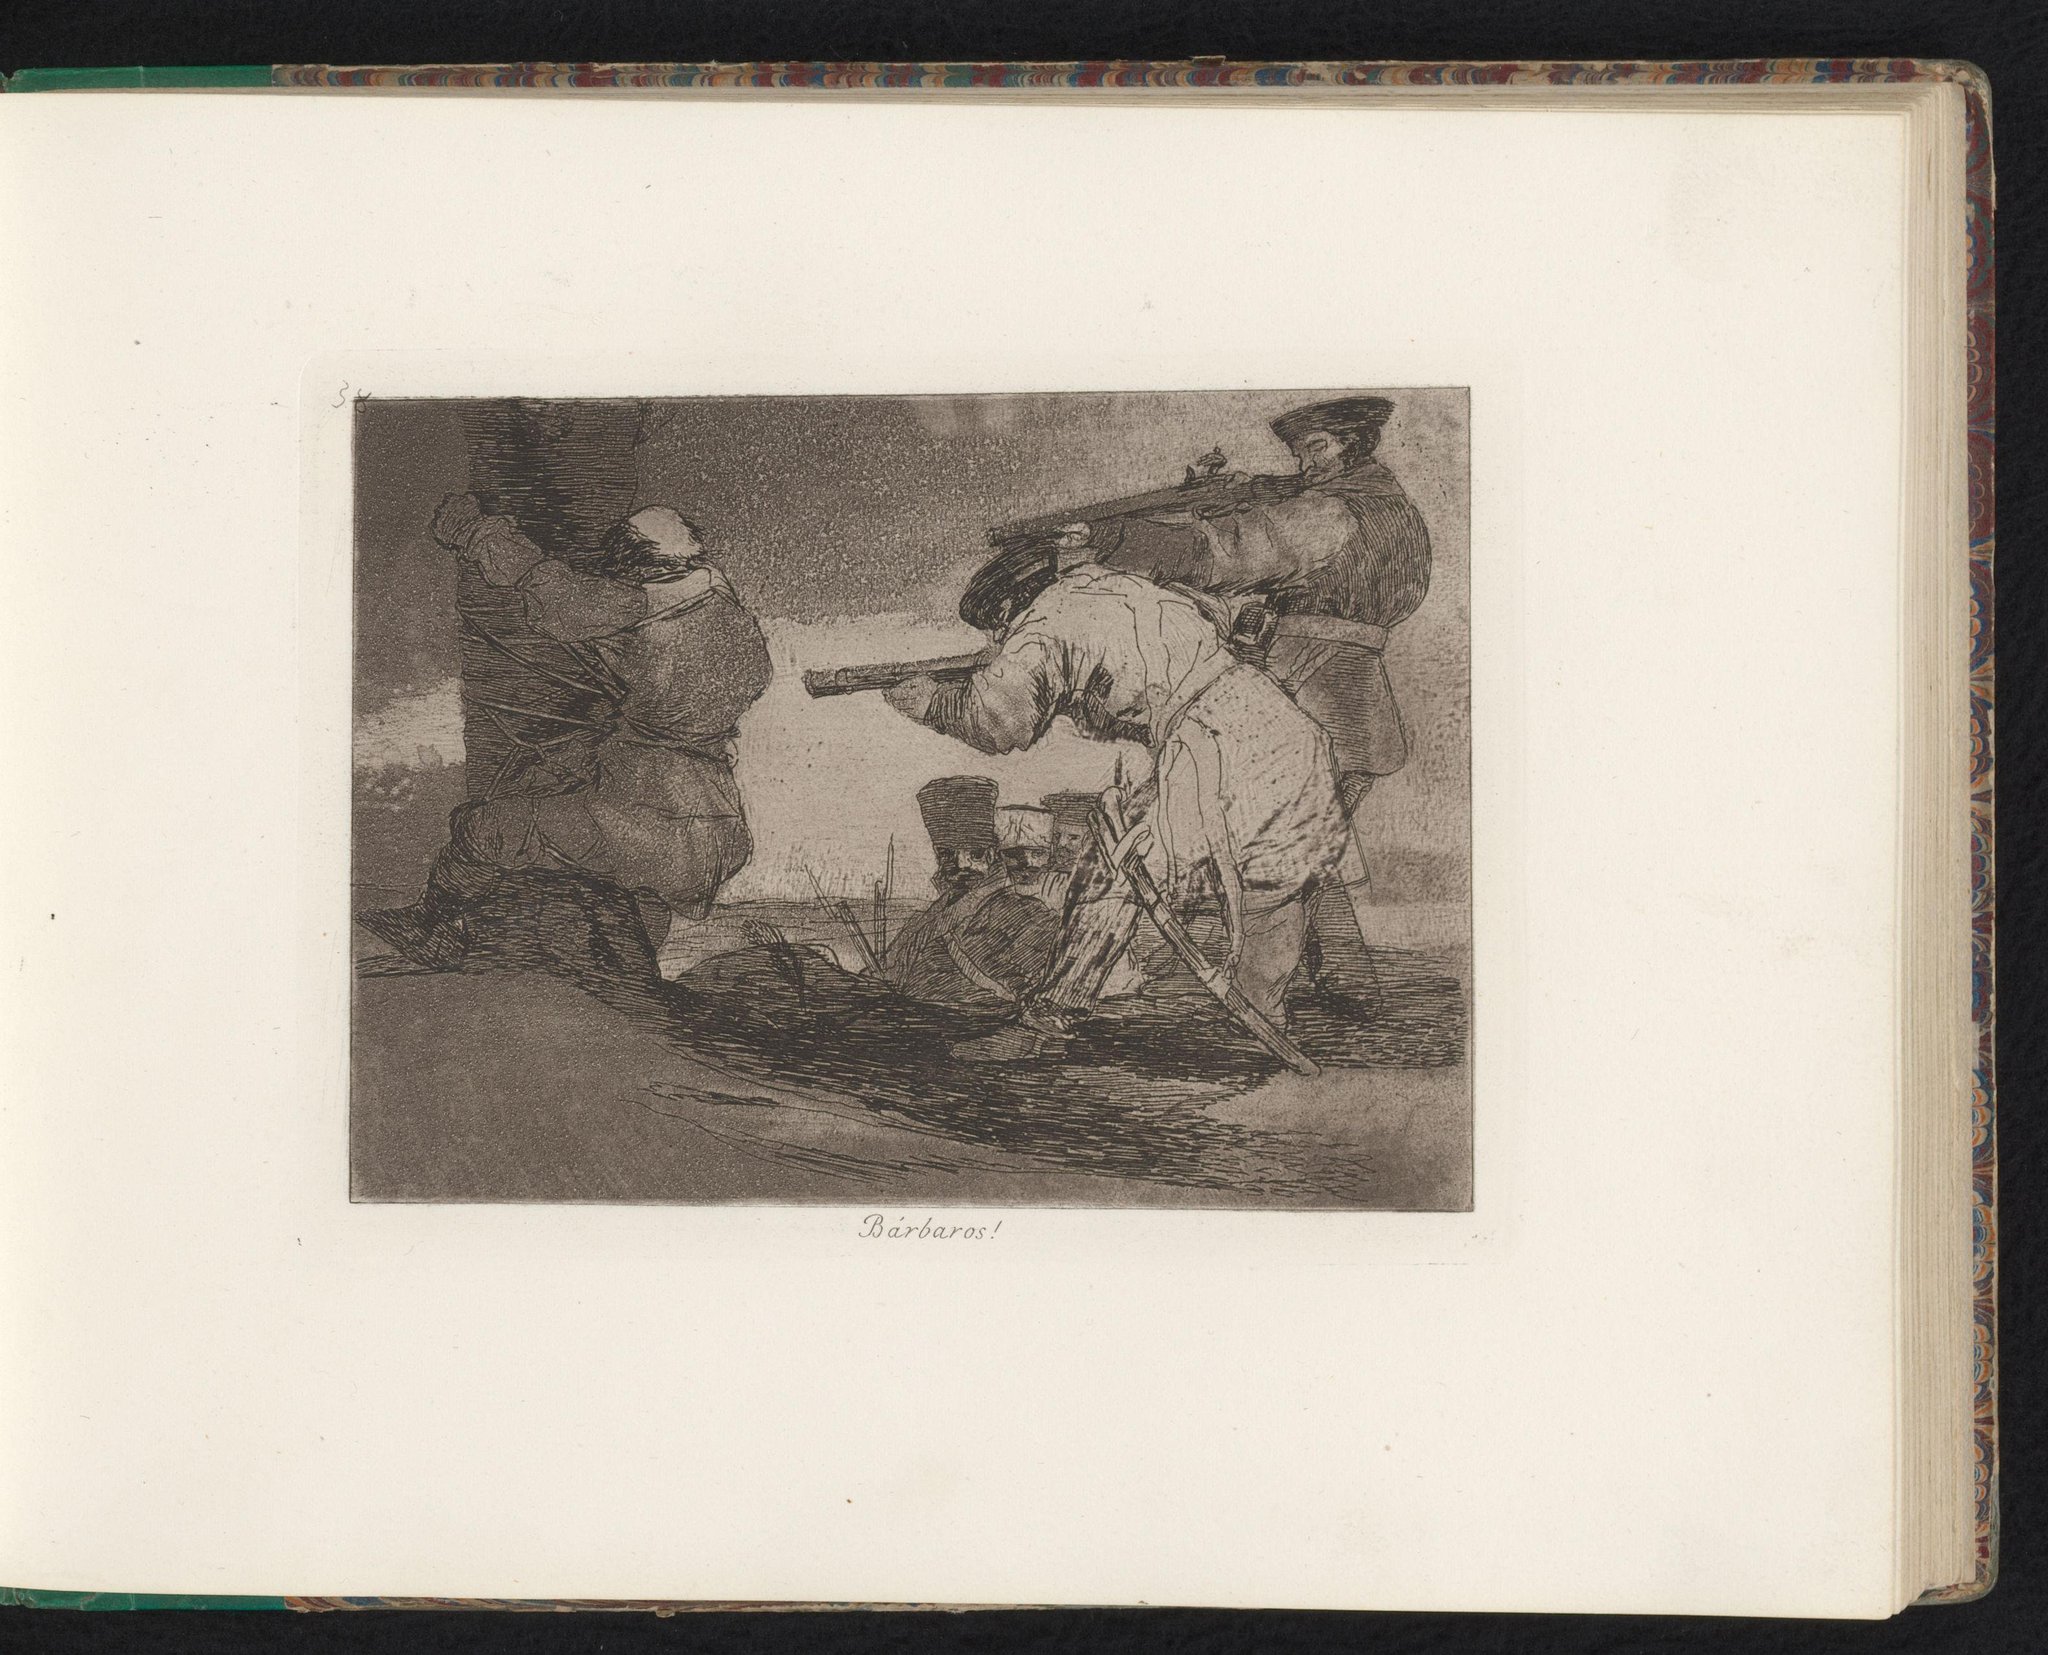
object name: print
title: Twee mannen richten hun geweren op de rug van een aan een boom geknevelde persoon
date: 1810-1820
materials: paper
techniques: aquatint, engraving, etching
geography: madrid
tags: horrors of war, prisoner with hands bound, violent death by fusillade, spain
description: Deze prent maakt deel uit van een album.